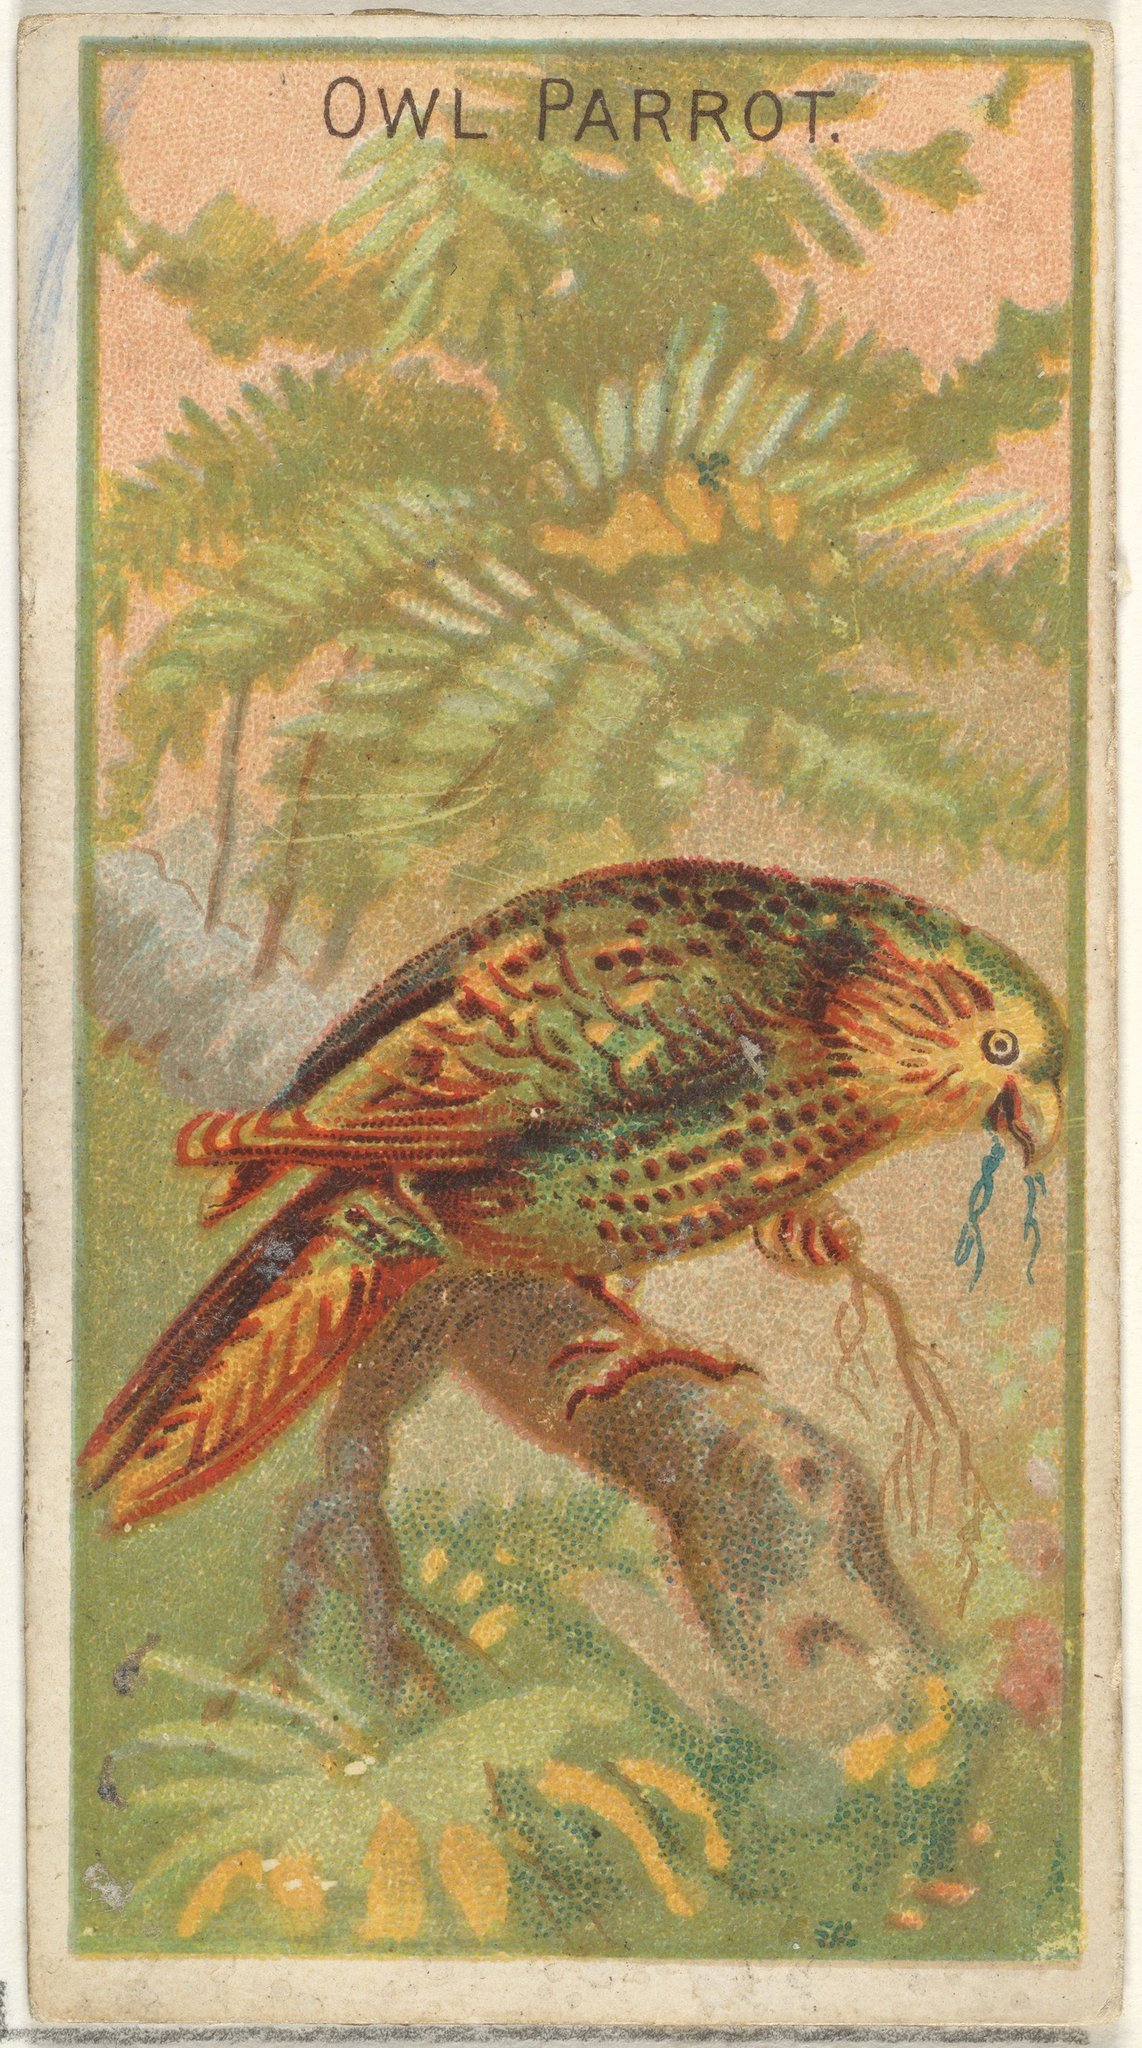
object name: print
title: Owl Parrot, from the Birds of the Tropics series (N5) for Allen & Ginter Cigarettes Brands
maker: allen & ginter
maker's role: publisher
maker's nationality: american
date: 1889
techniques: color lithograph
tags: birds